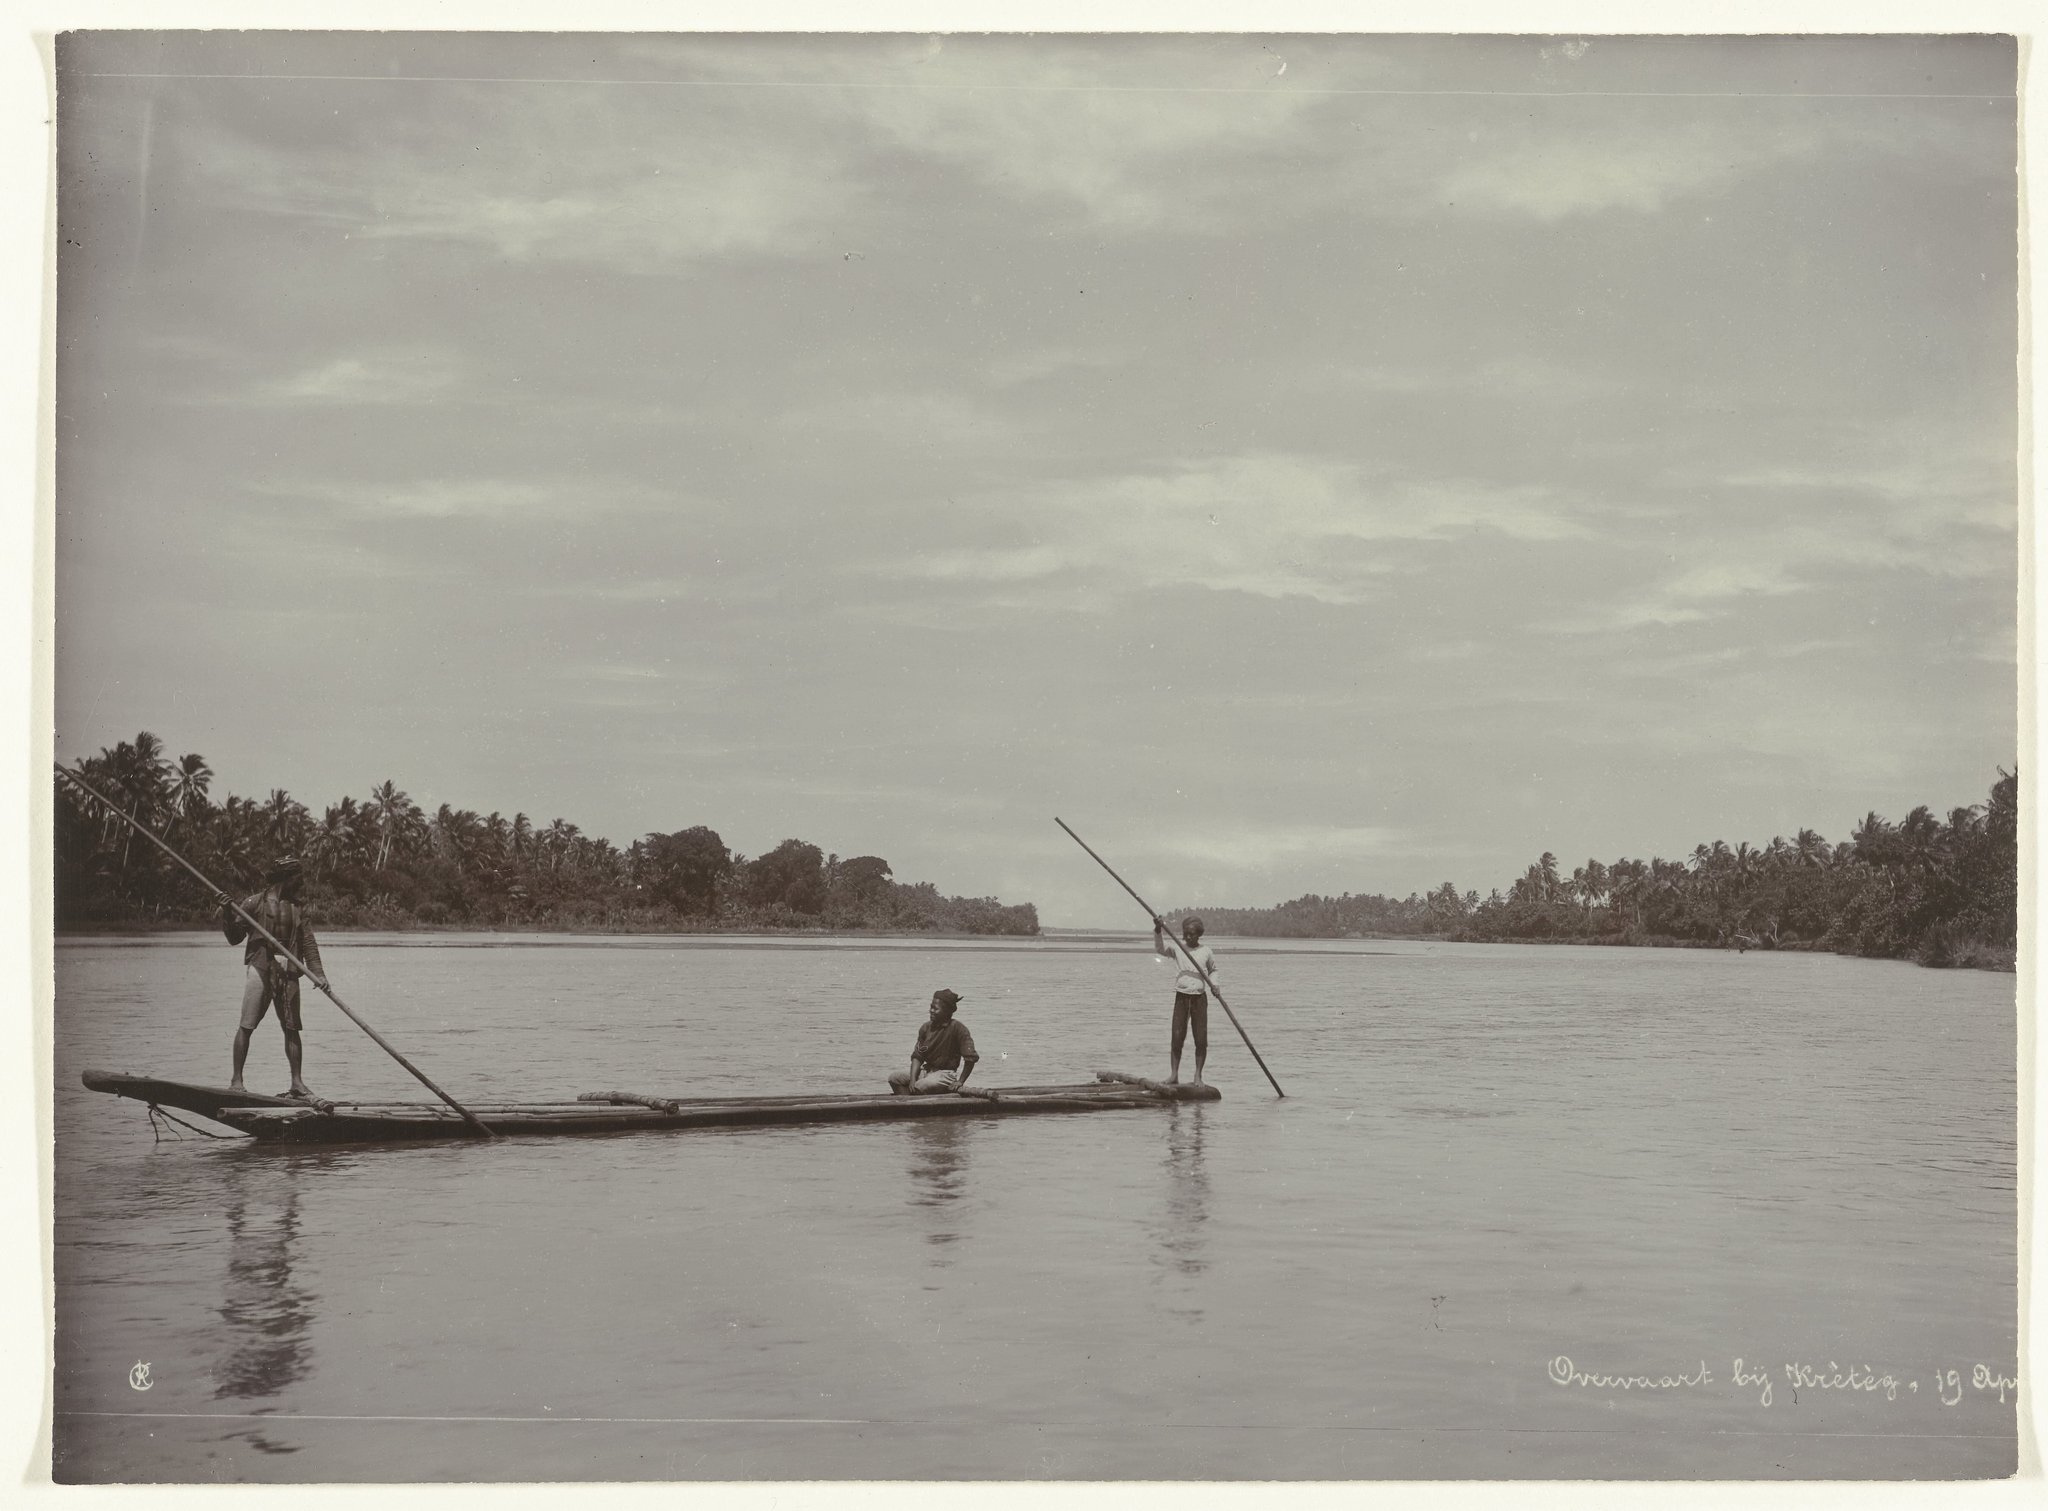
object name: photograph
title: Overvaart bij Kreteg (...)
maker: kassian céphas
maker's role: fotograaf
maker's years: 1845-1912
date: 1867-1910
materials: cardboard, paper, photographic support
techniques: albumen print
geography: java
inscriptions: signature: ‘KC’